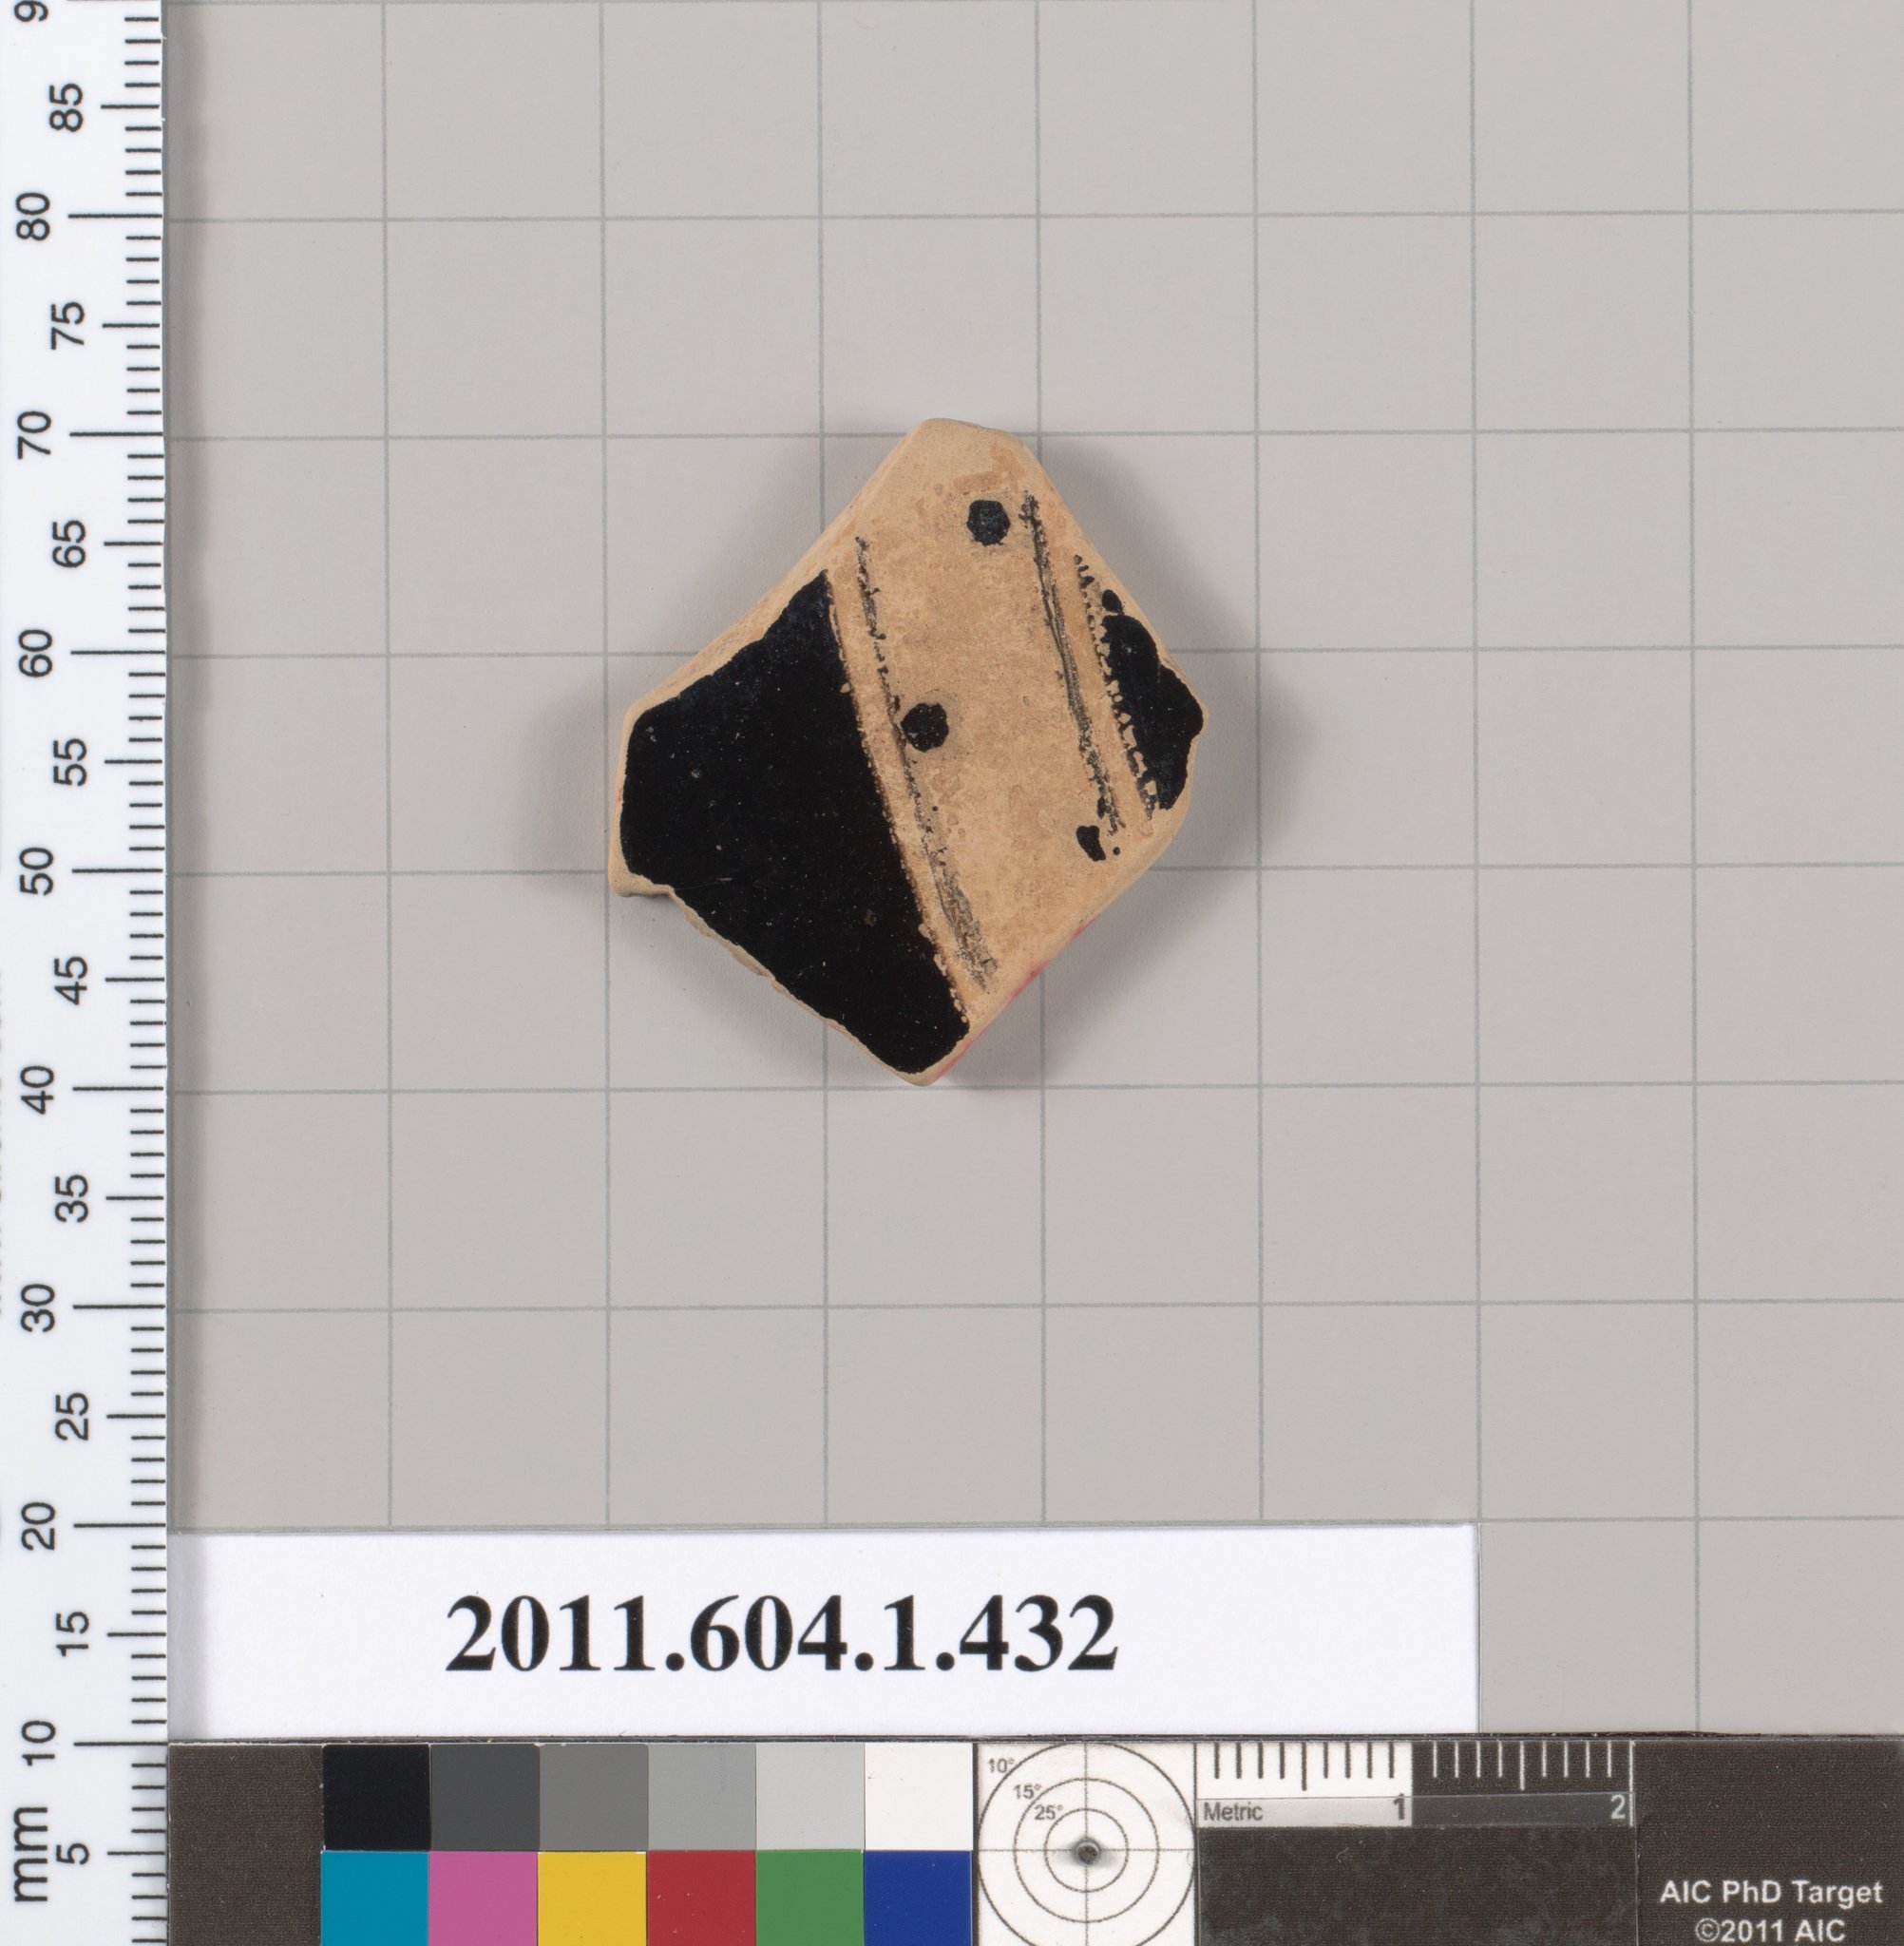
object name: kylix fragment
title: Terracotta fragment of a kylix (drinking cup)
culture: greek, attic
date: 475-451 BCE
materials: terracotta